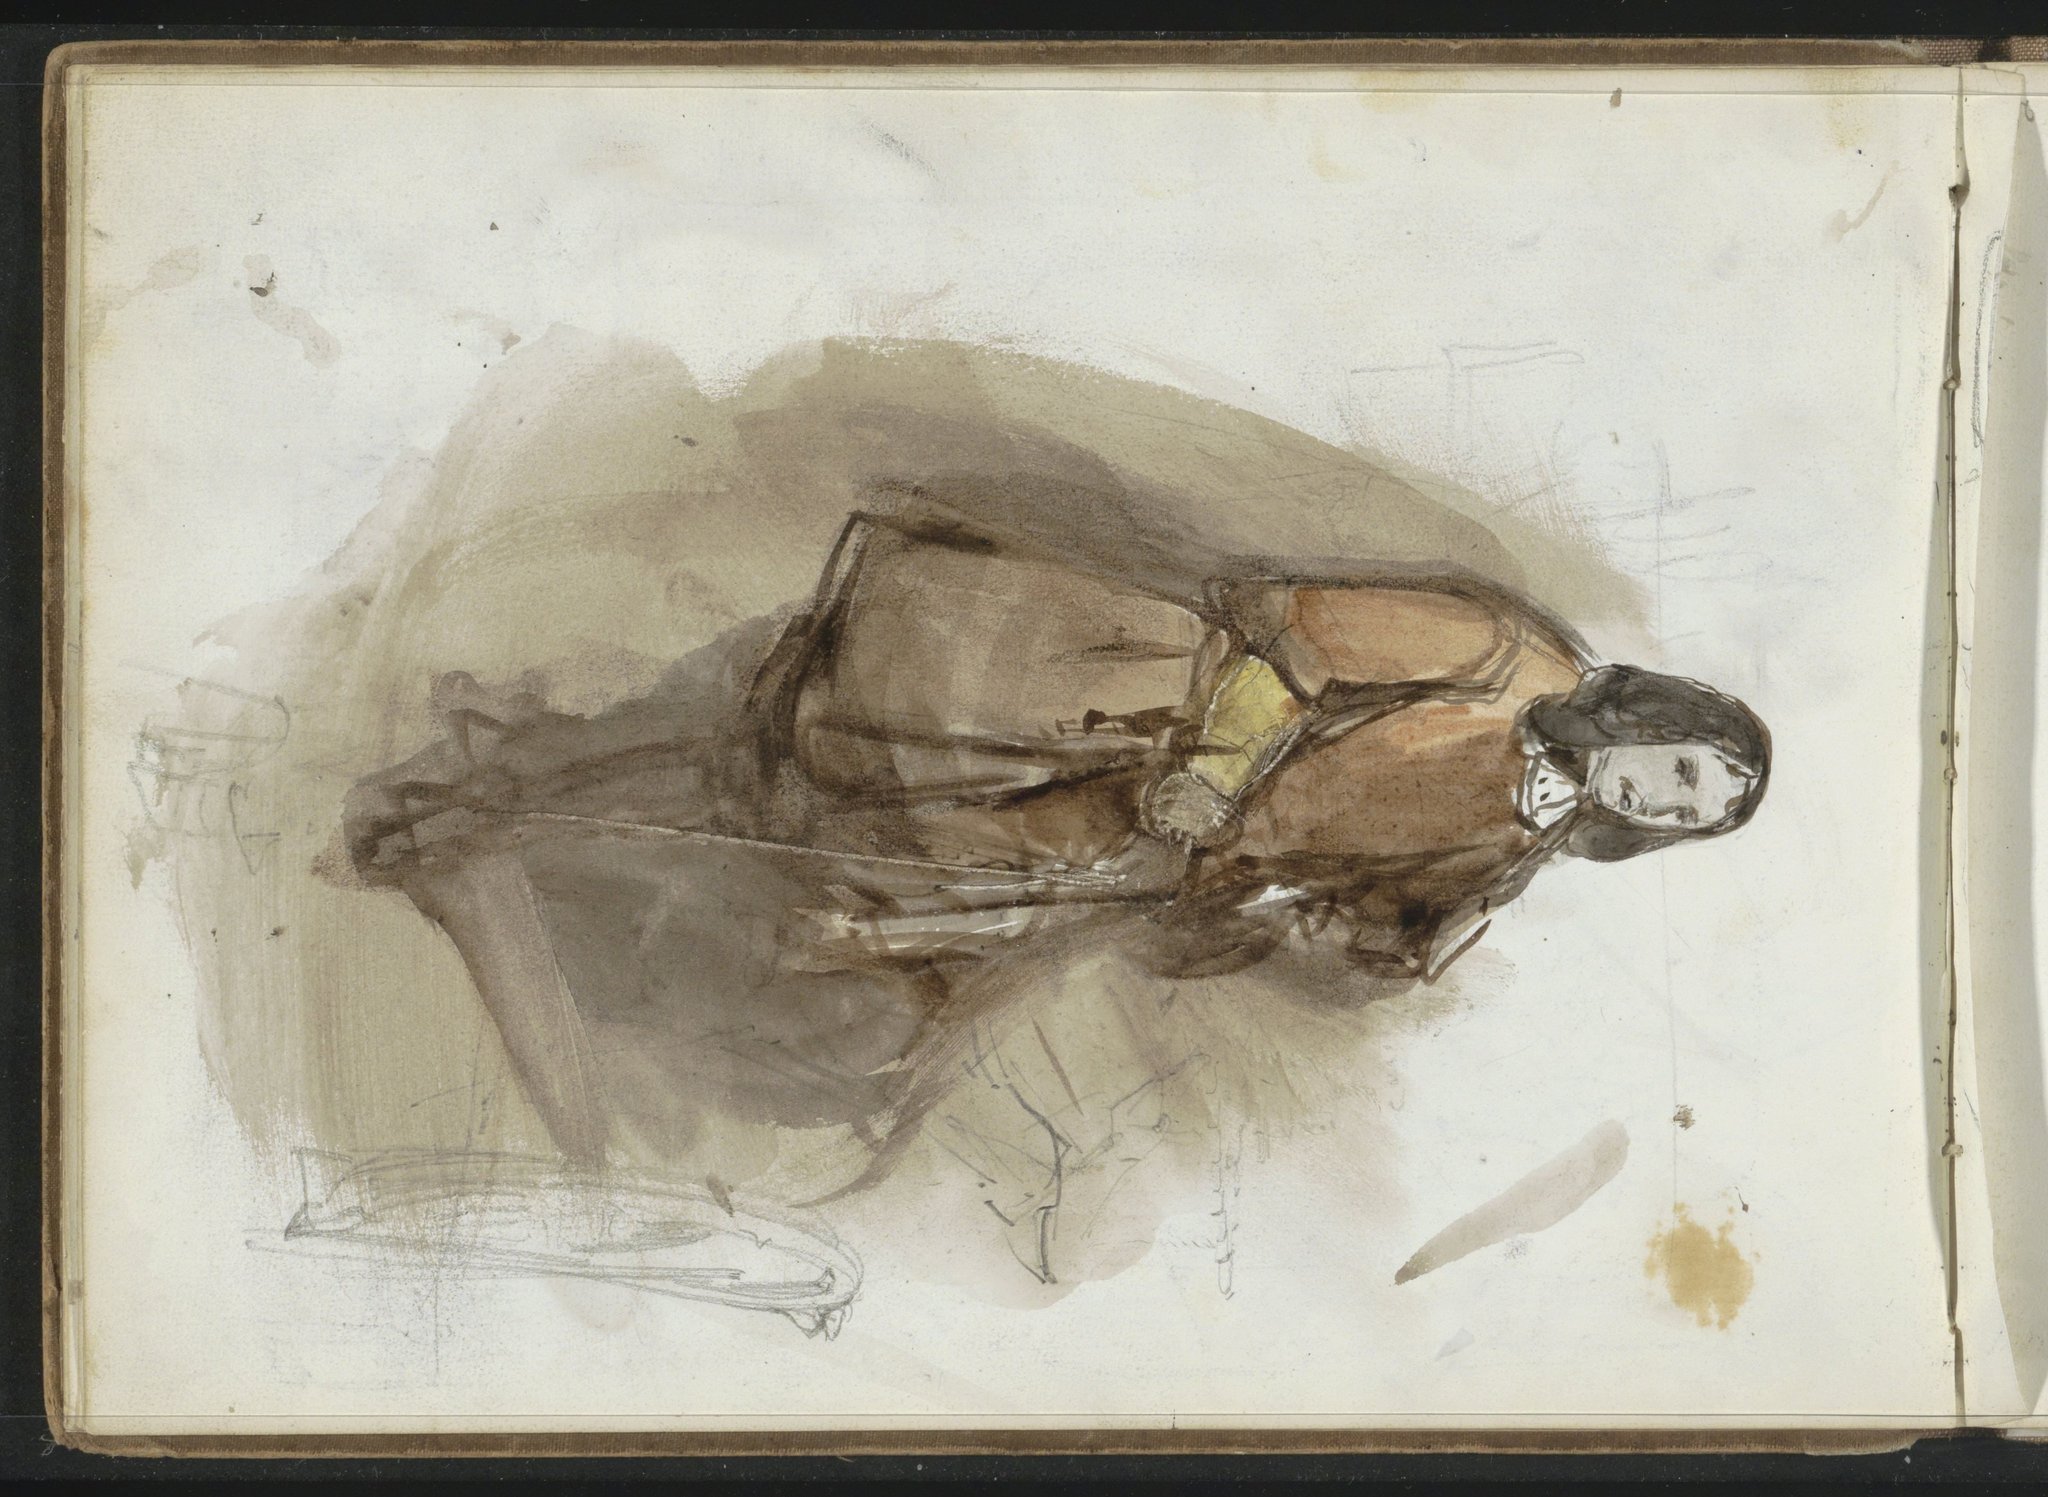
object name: sketchbook leaf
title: Mansportret, vermoedelijk een kopie naar een zeventiende-eeuws schilderij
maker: johannes bosboom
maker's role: draughtsman, painter, print maker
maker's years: 1817-1891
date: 1827-1891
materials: paper, pencil, watercolor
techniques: brush, scoring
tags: adult man, historical costume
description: Blad 9 verso uit een schetsboek met 41 pagina's.